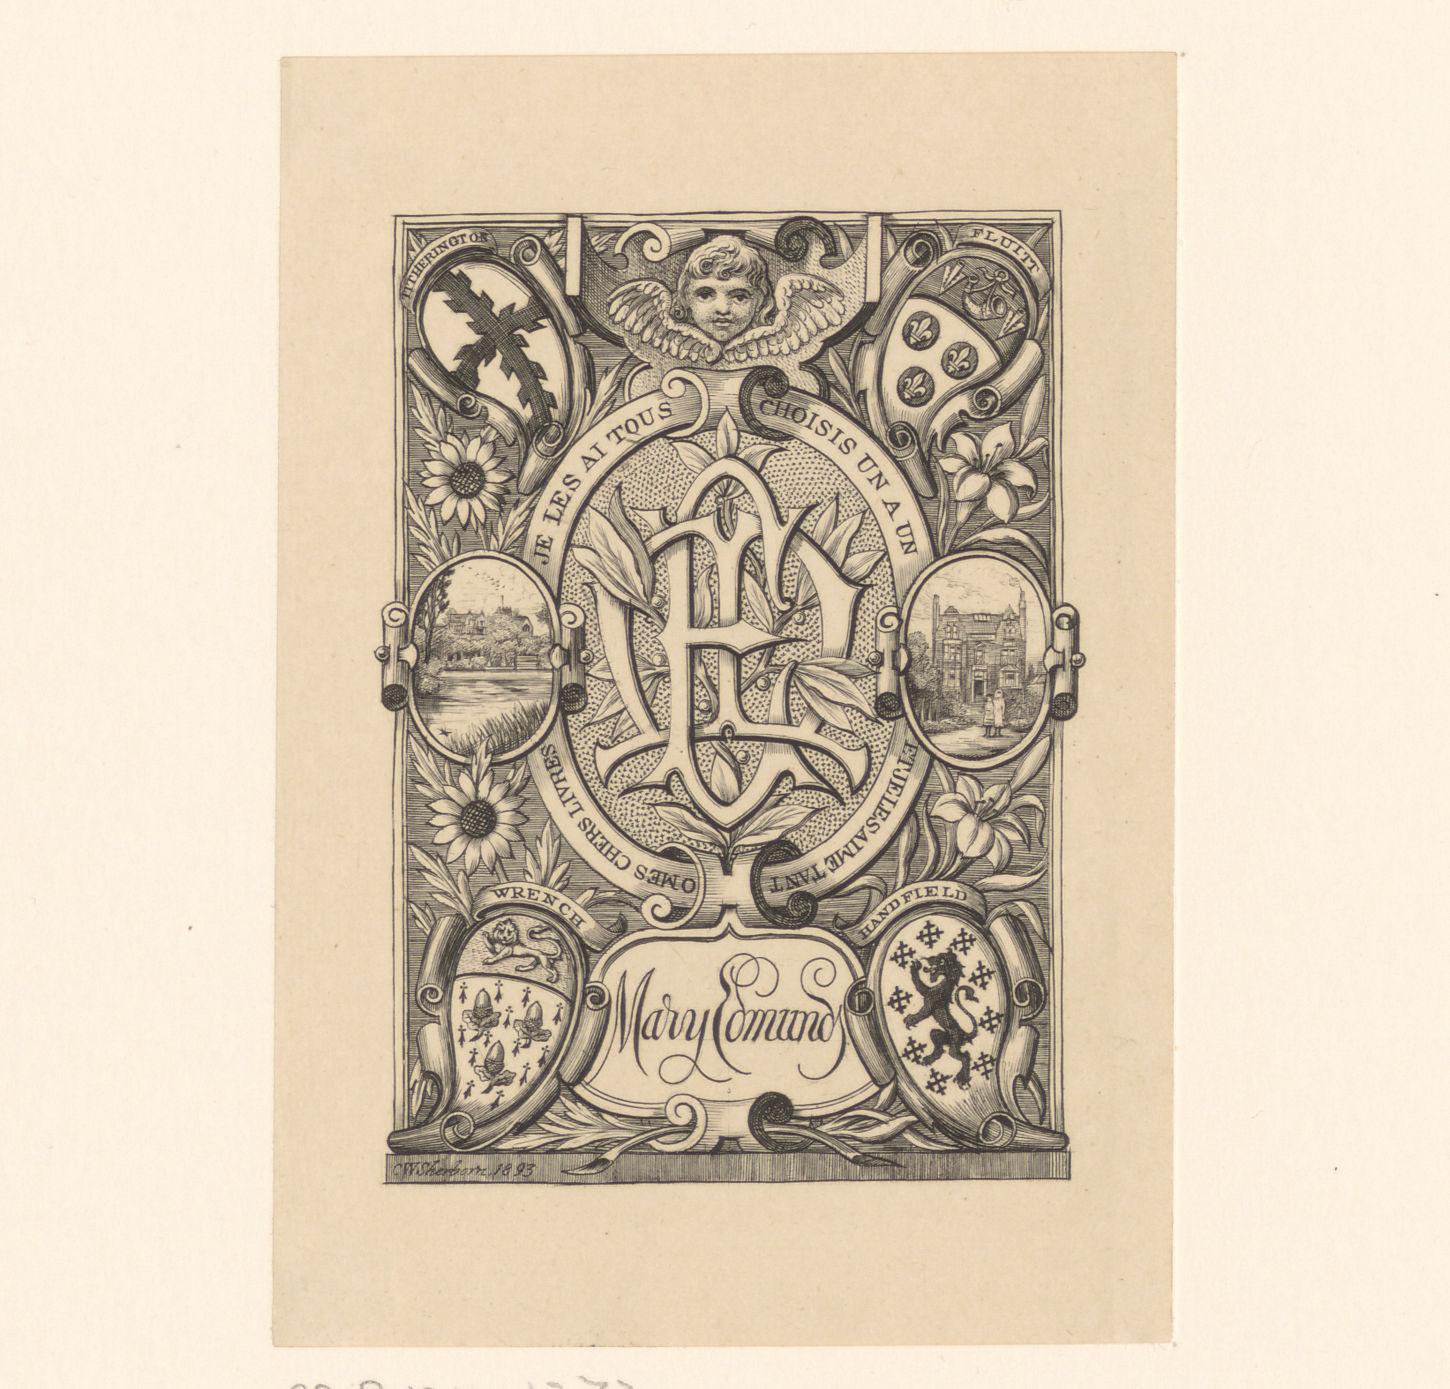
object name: bookplate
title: Ex libris van Mary Edmunds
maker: charles william sherborn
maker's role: print maker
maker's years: 1831-1912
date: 1893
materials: paper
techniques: engraving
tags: foliage ~ ornament, rural housing, e.g. country-house, villa, cottage, cupids: 'amores', 'amoretti', 'putti', armorial bearing, heraldry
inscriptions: collector's mark: Lugt 2228